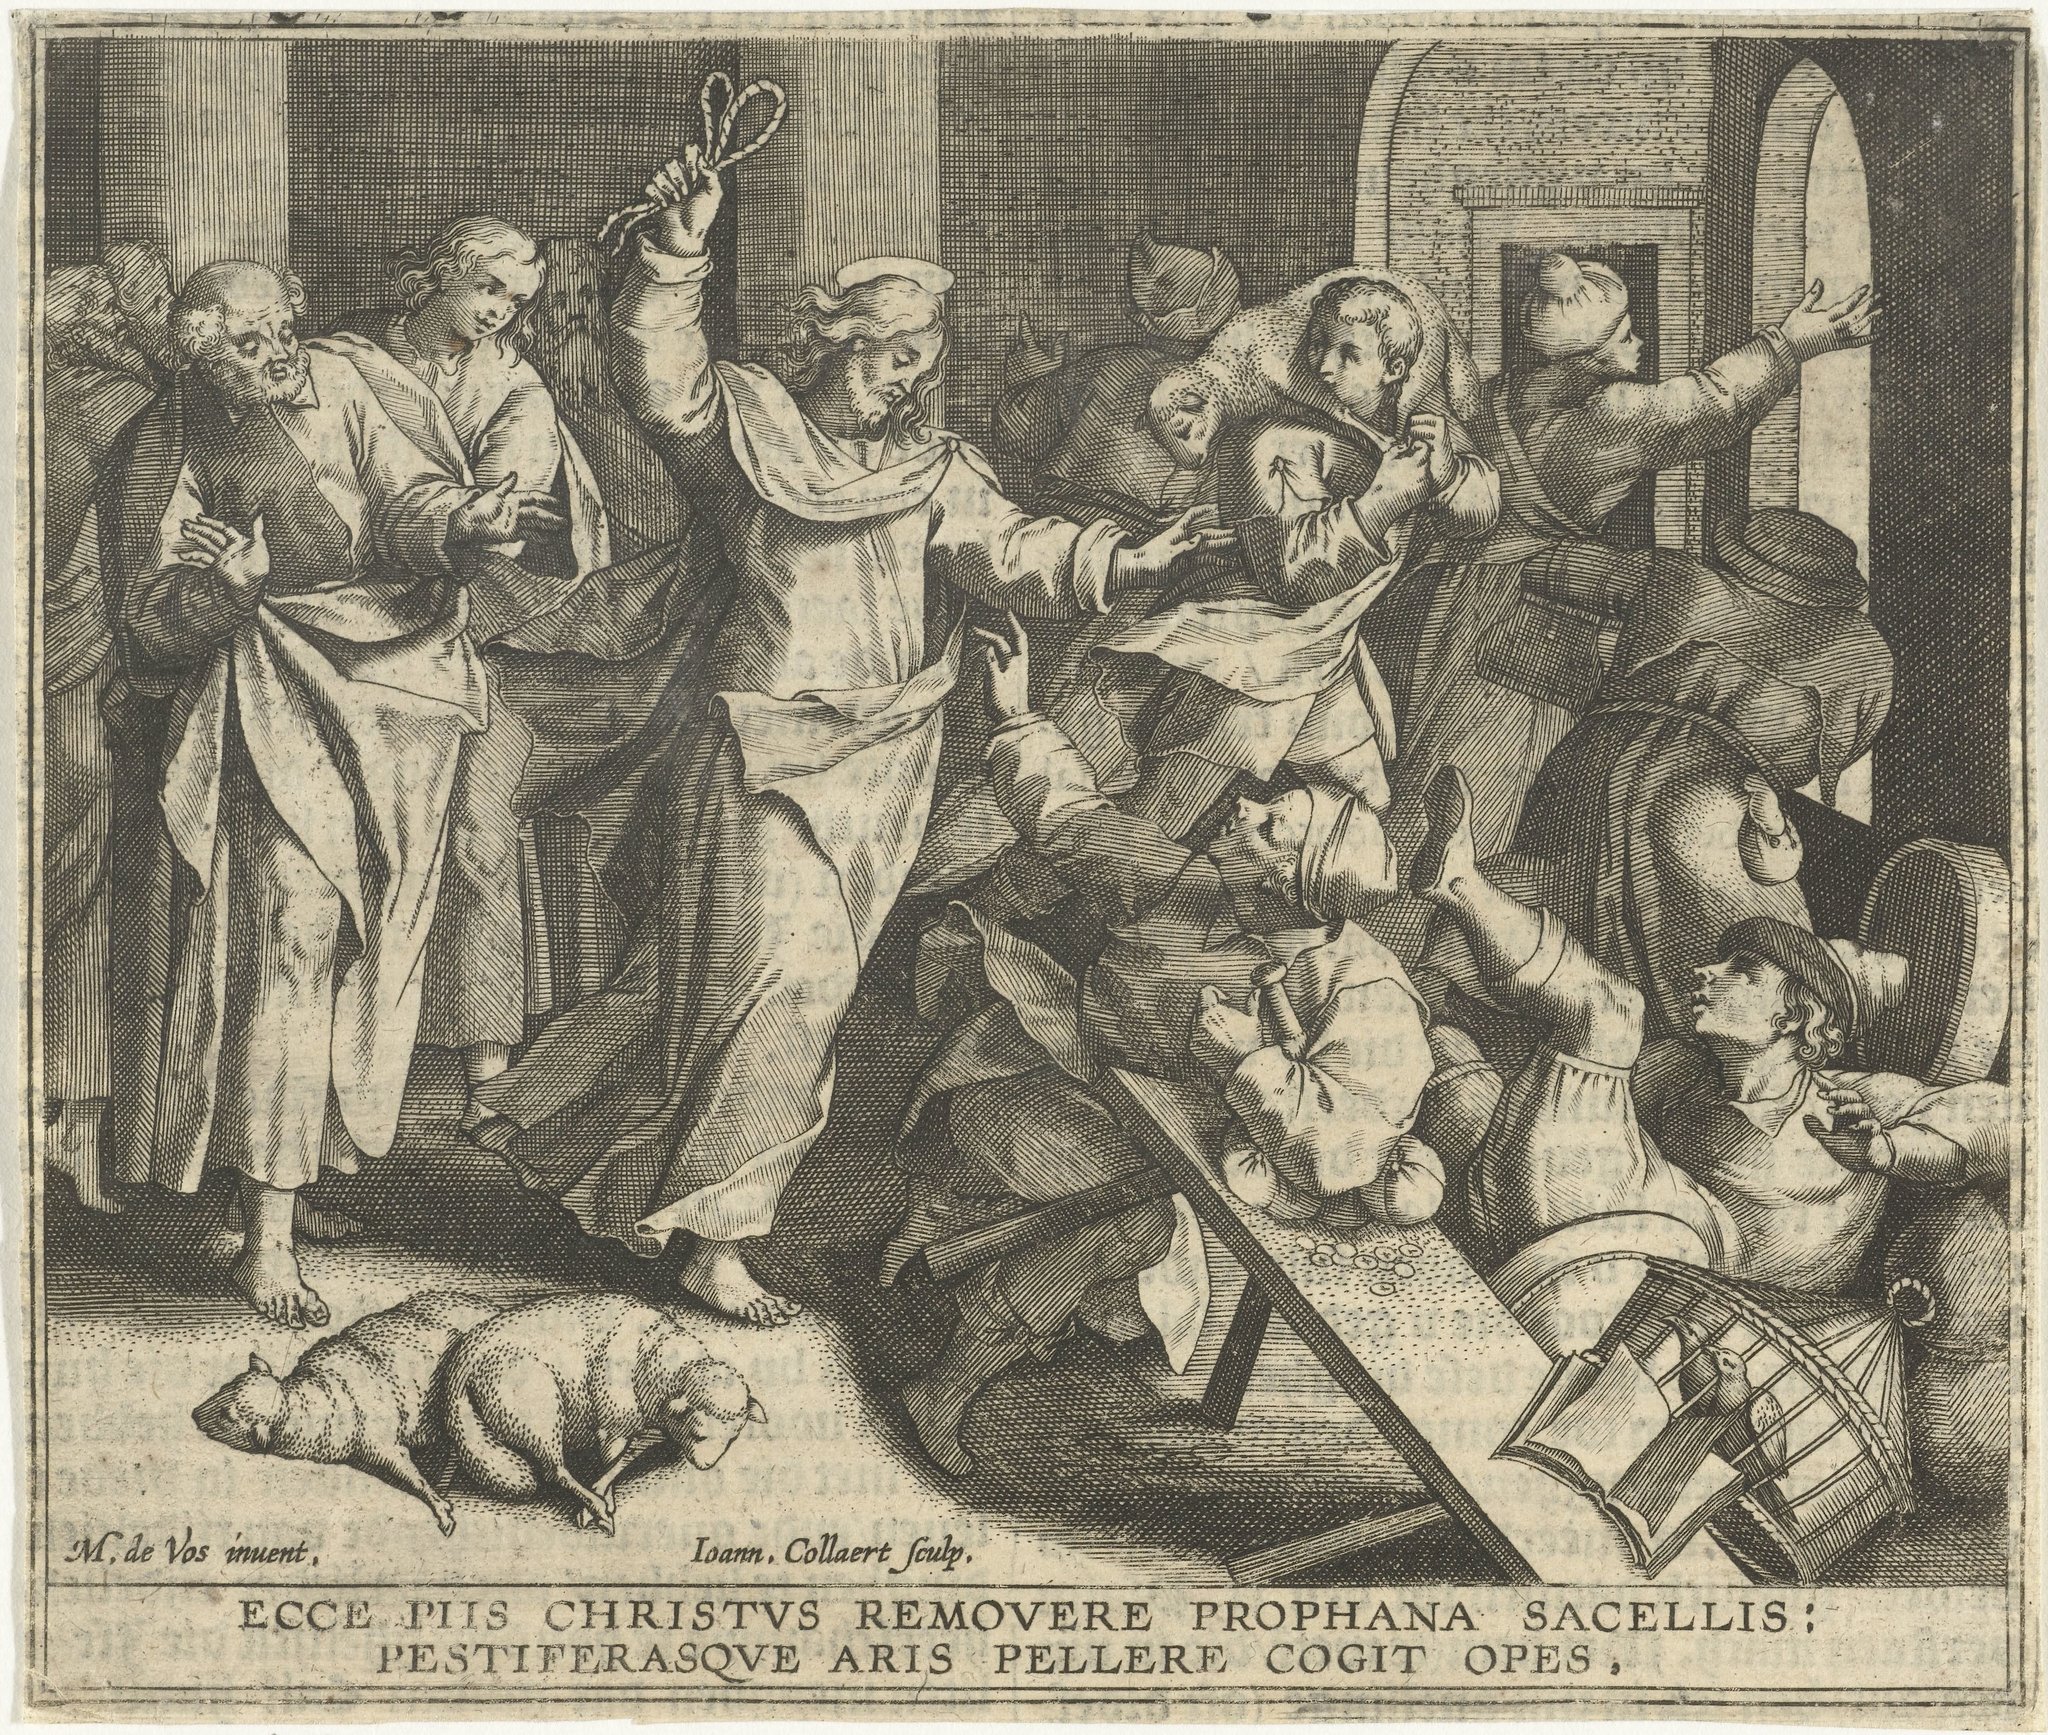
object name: print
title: Verdrijving van de geldwisselaars uit de tempel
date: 1597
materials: paper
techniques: engraving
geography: antwerp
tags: purification of the temple ('first' and 'second'): christ driving the money-changers from the temple with a whip (matthew 21:12-13; mark 11:15-17; luke 19:45-46; john 12:12-19)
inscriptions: collector's mark: Lugt 2228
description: Christus jaagt de geldwisselaars en de marktkramers uit de tempel van Jerusalem. De prent heeft een Latijns onderschrift.